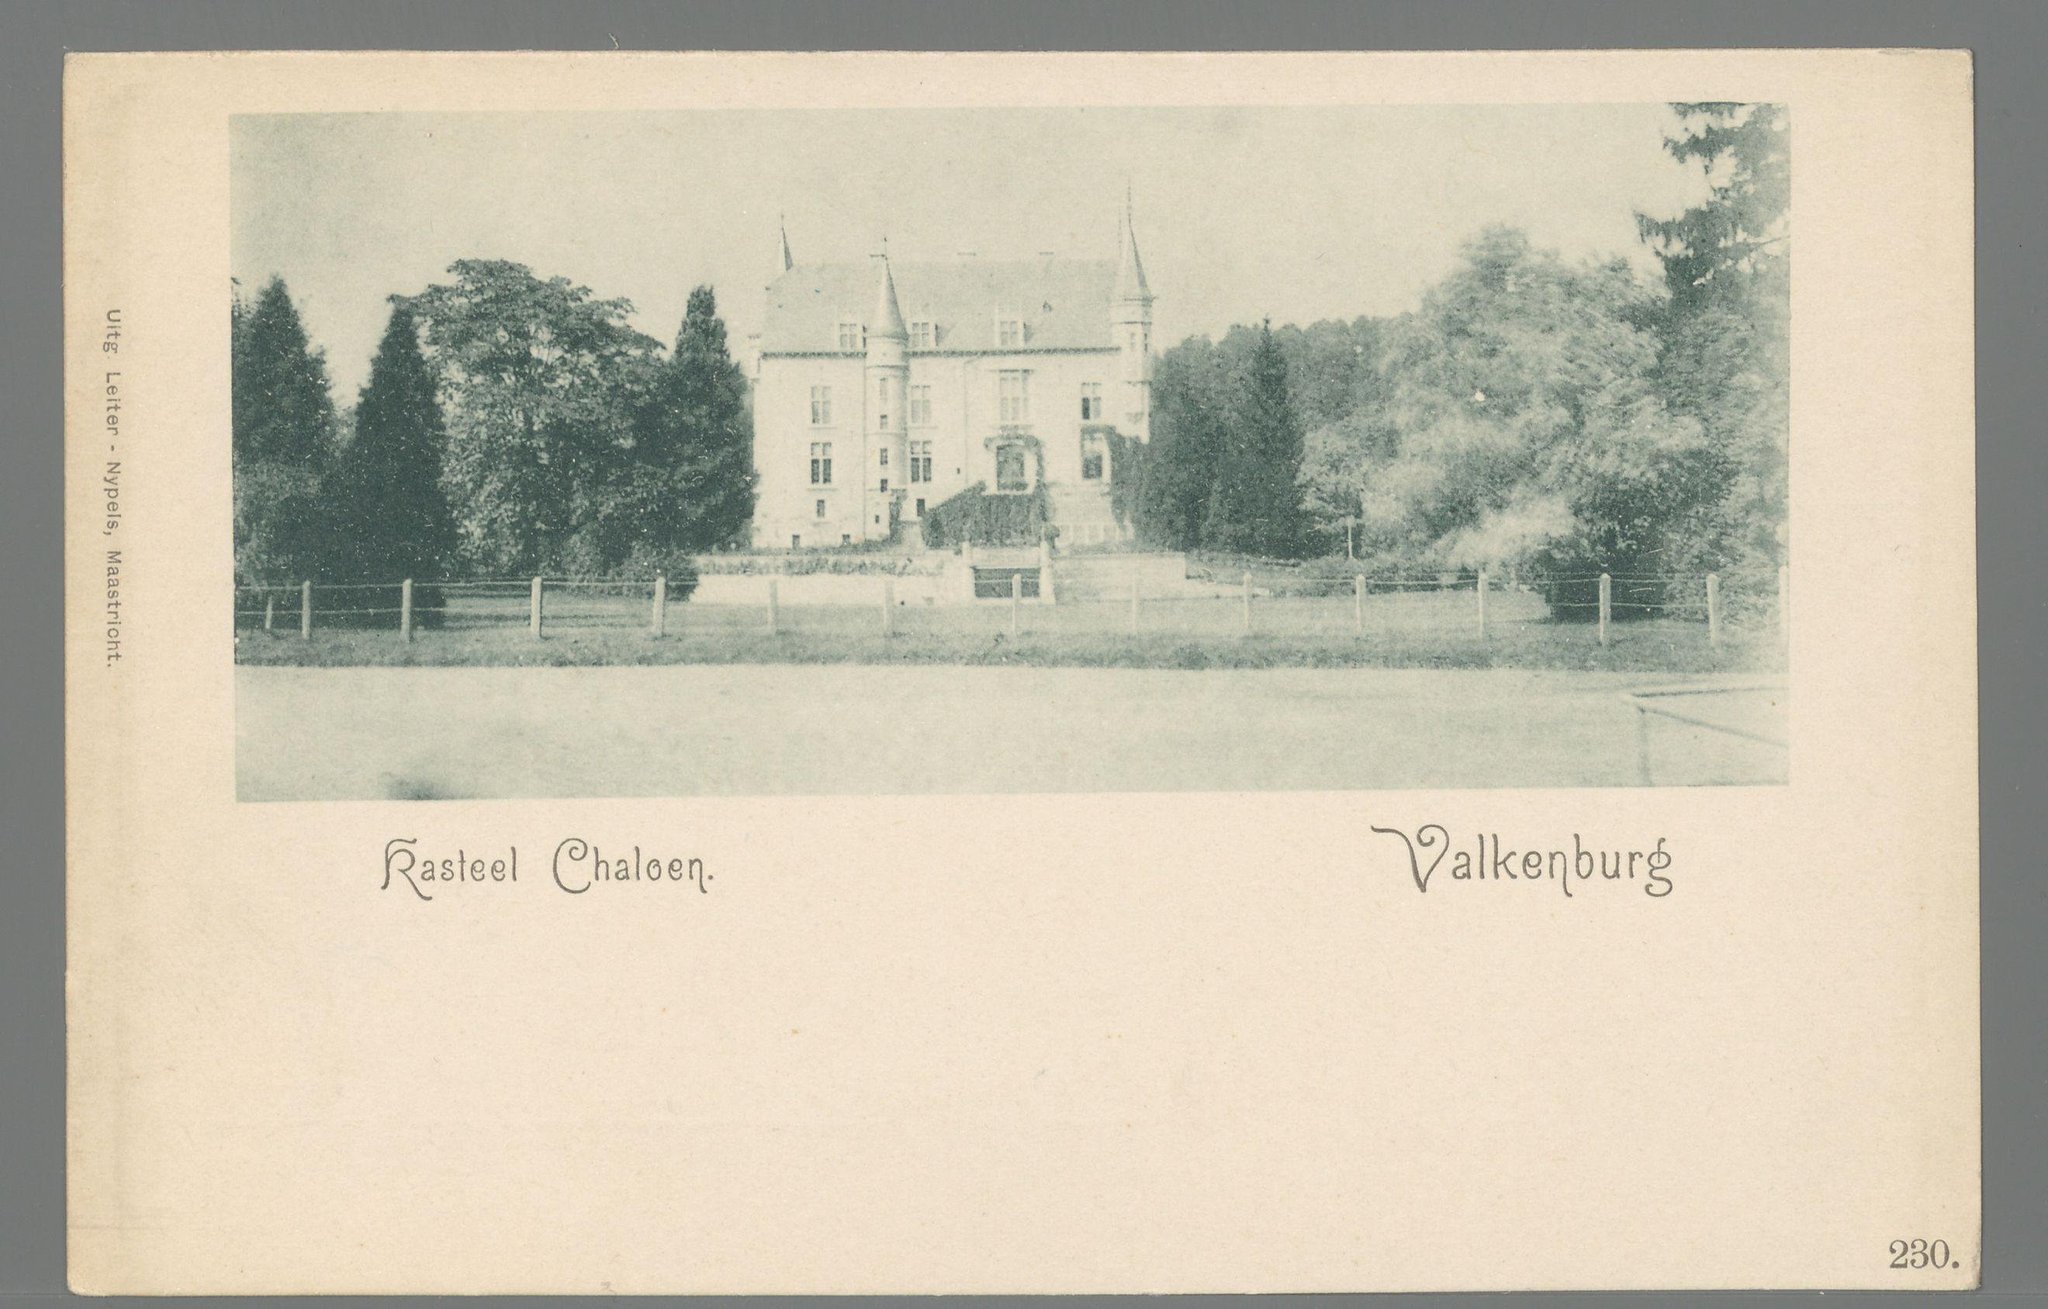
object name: photomechanical print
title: Kasteel Chaloen. Valkenburg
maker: Anonymous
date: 1892-1905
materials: cardboard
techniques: photograph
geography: oud-valkenburg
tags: castle, canal